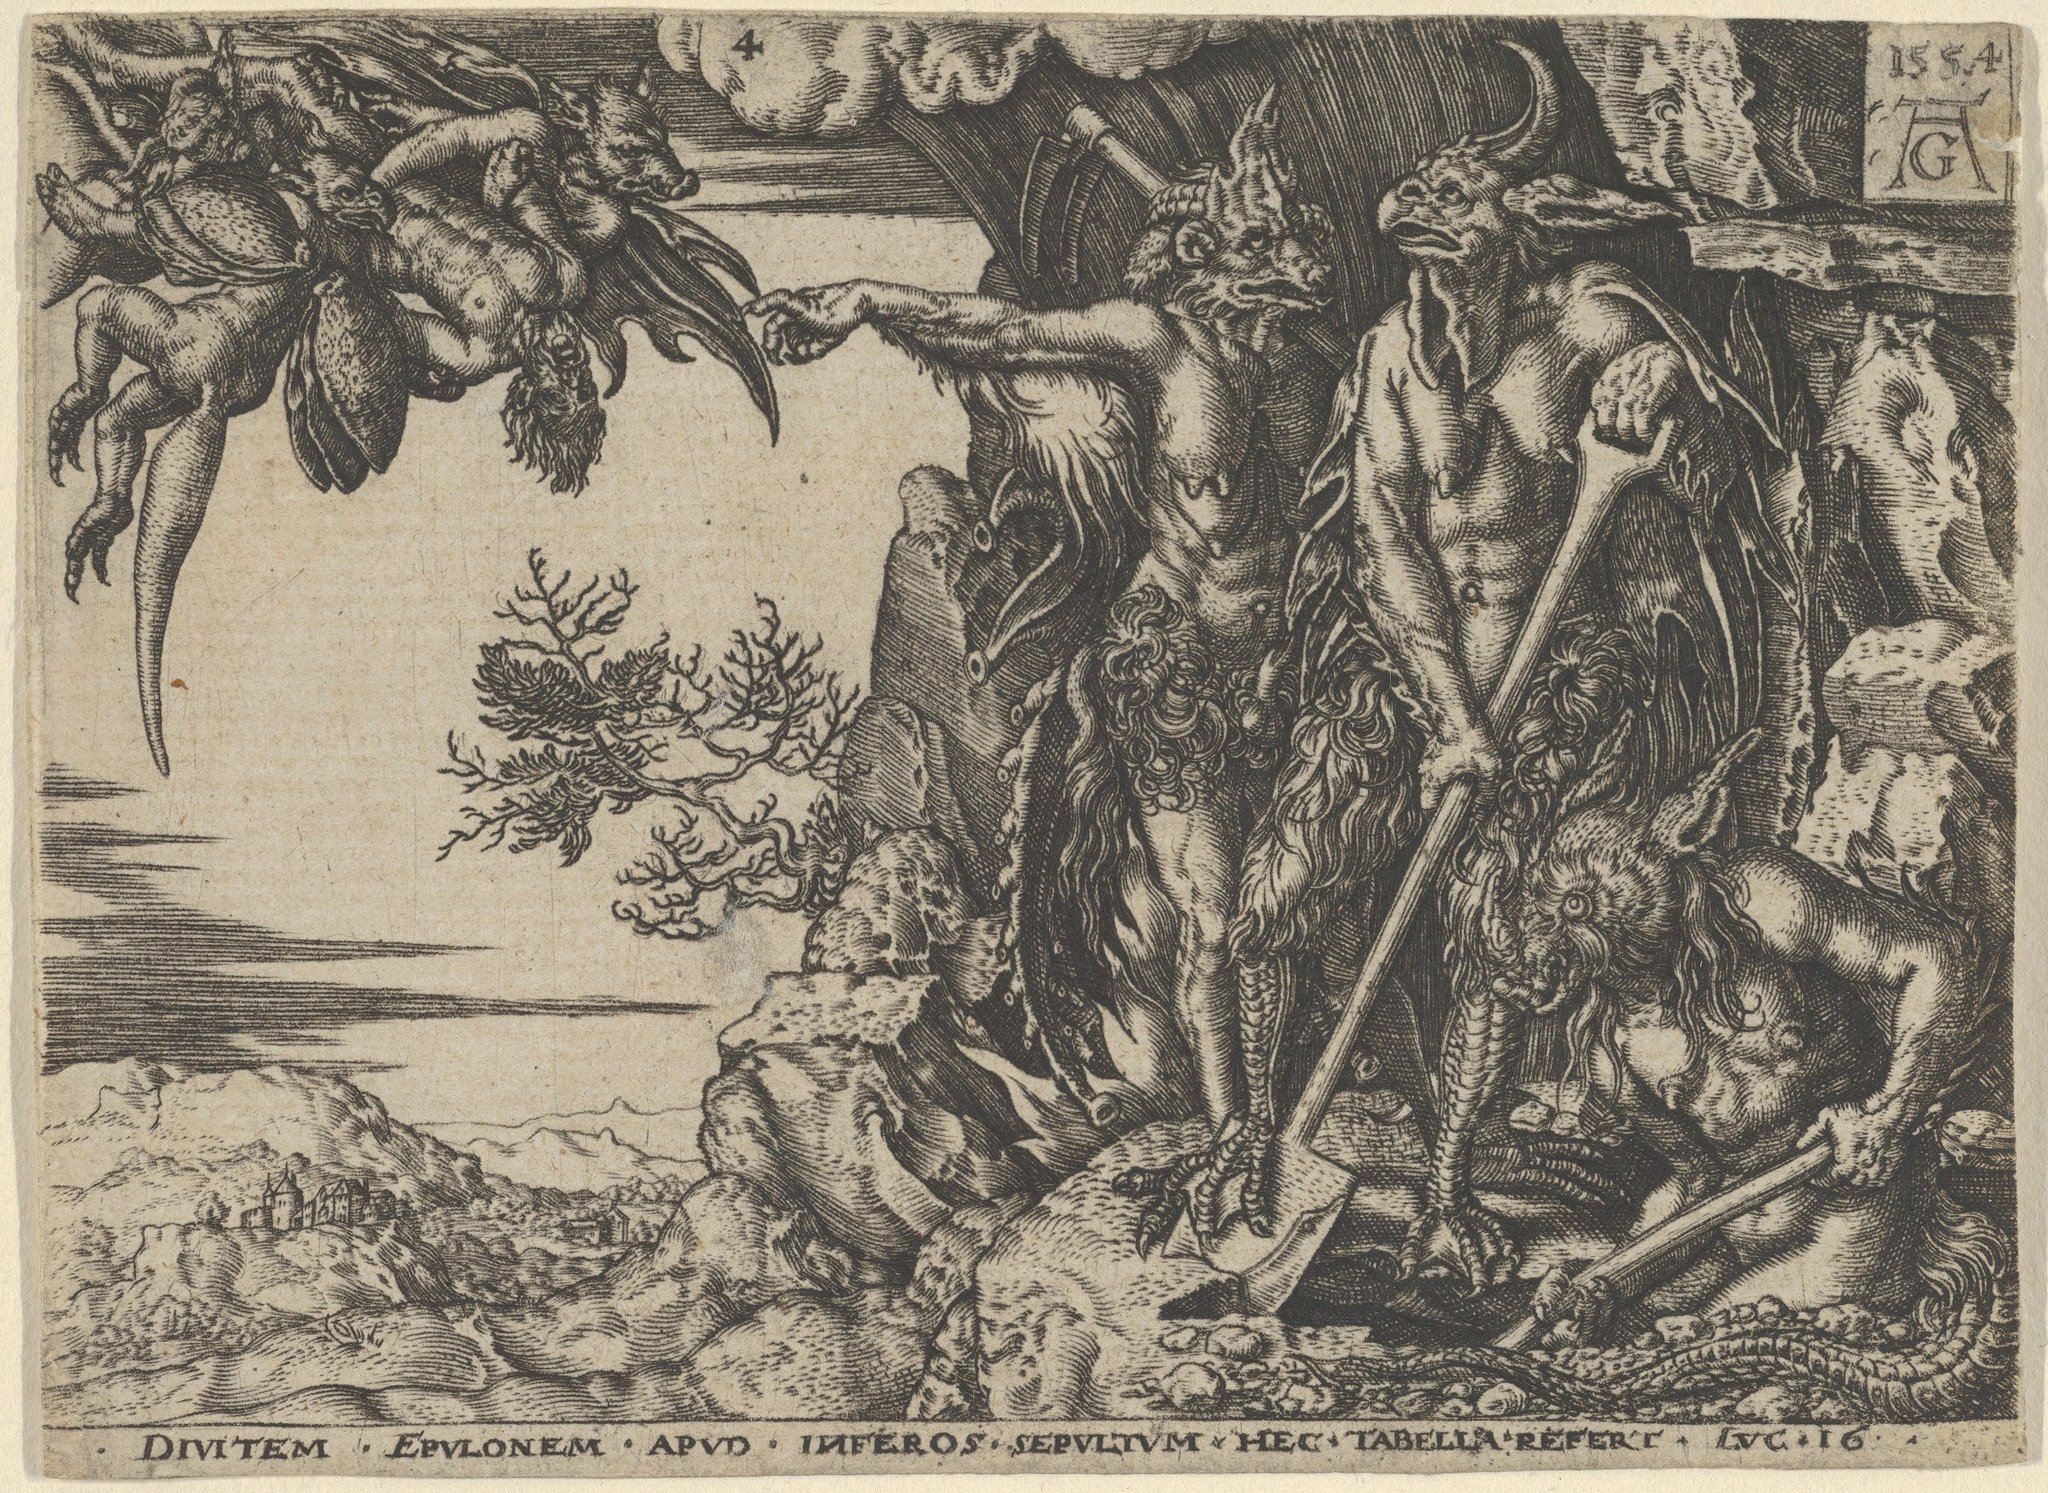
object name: print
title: Copy of The Rich Man Transported to Hell, from "The Parable of the Rich Man and Lazarus"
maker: heinrich aldegrever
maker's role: artist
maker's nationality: german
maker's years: 1502-1561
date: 1554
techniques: engraving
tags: demons,hell